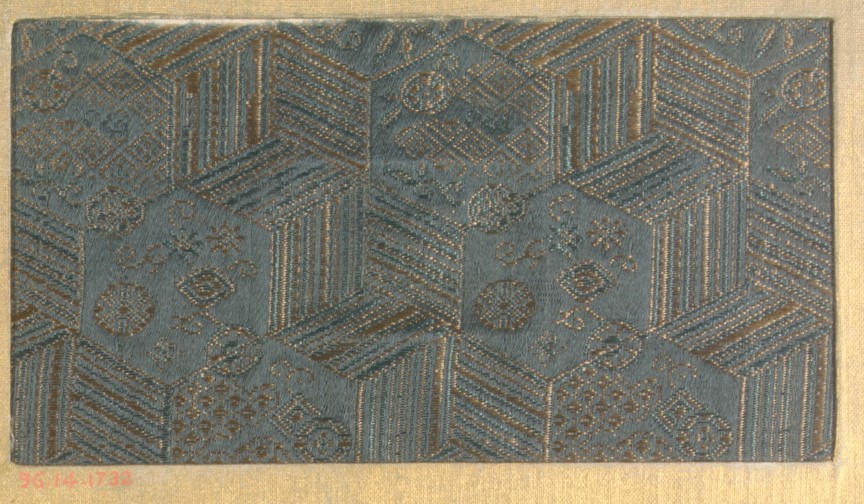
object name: piece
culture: japanese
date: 1701-1900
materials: silk